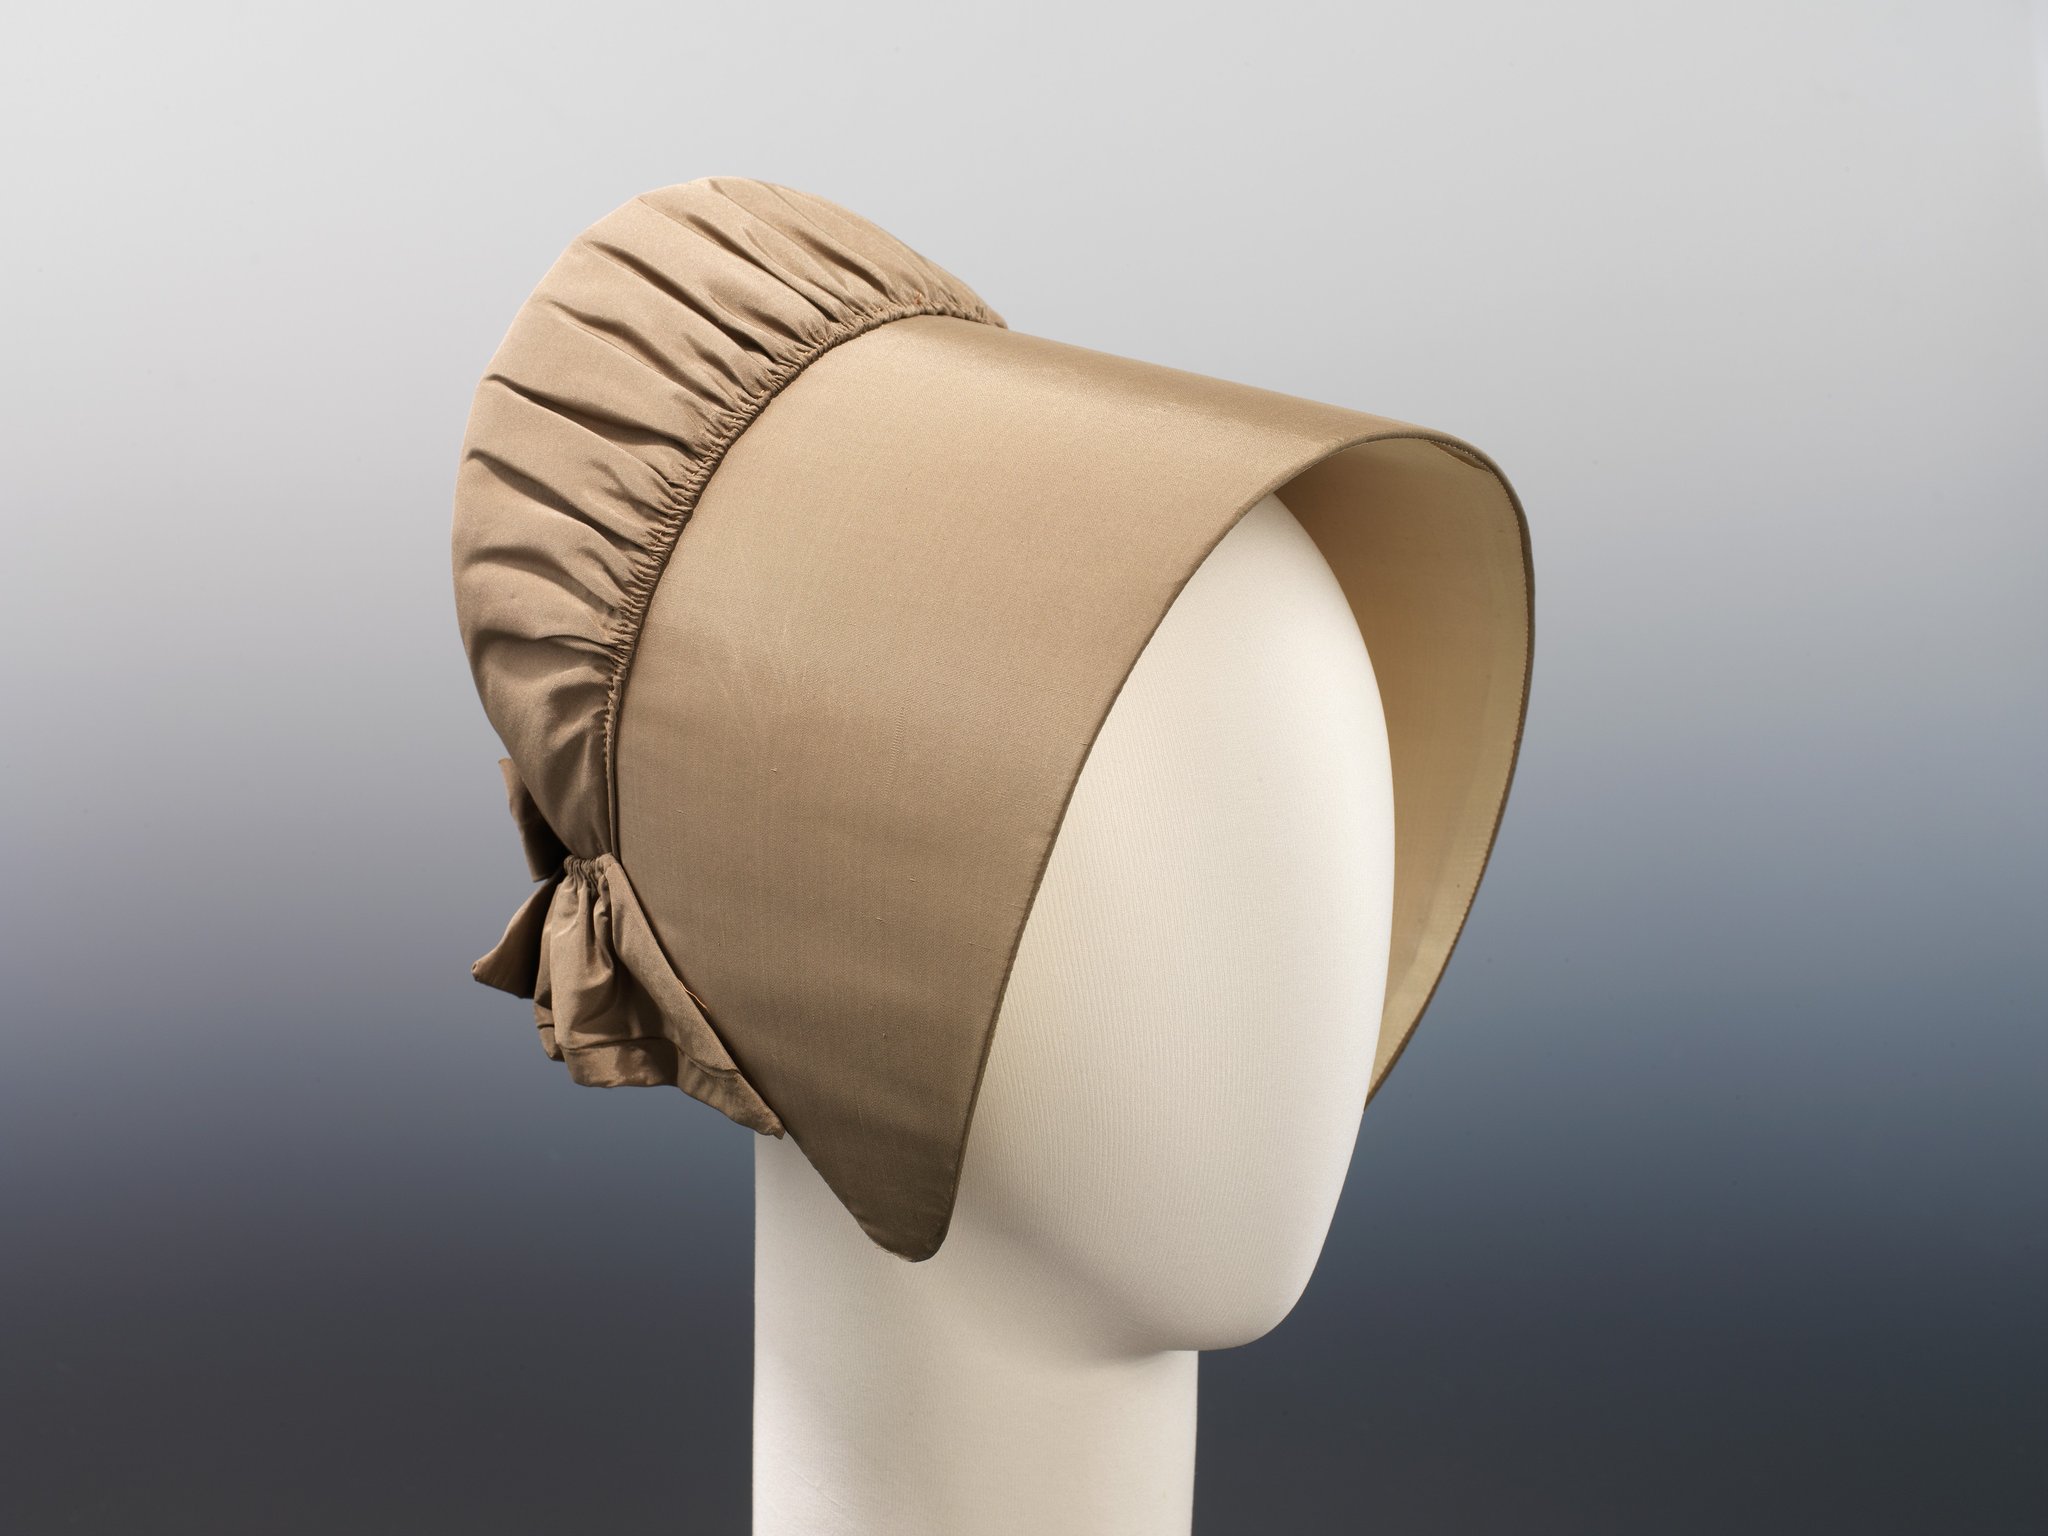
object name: bonnet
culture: american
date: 1850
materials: silk